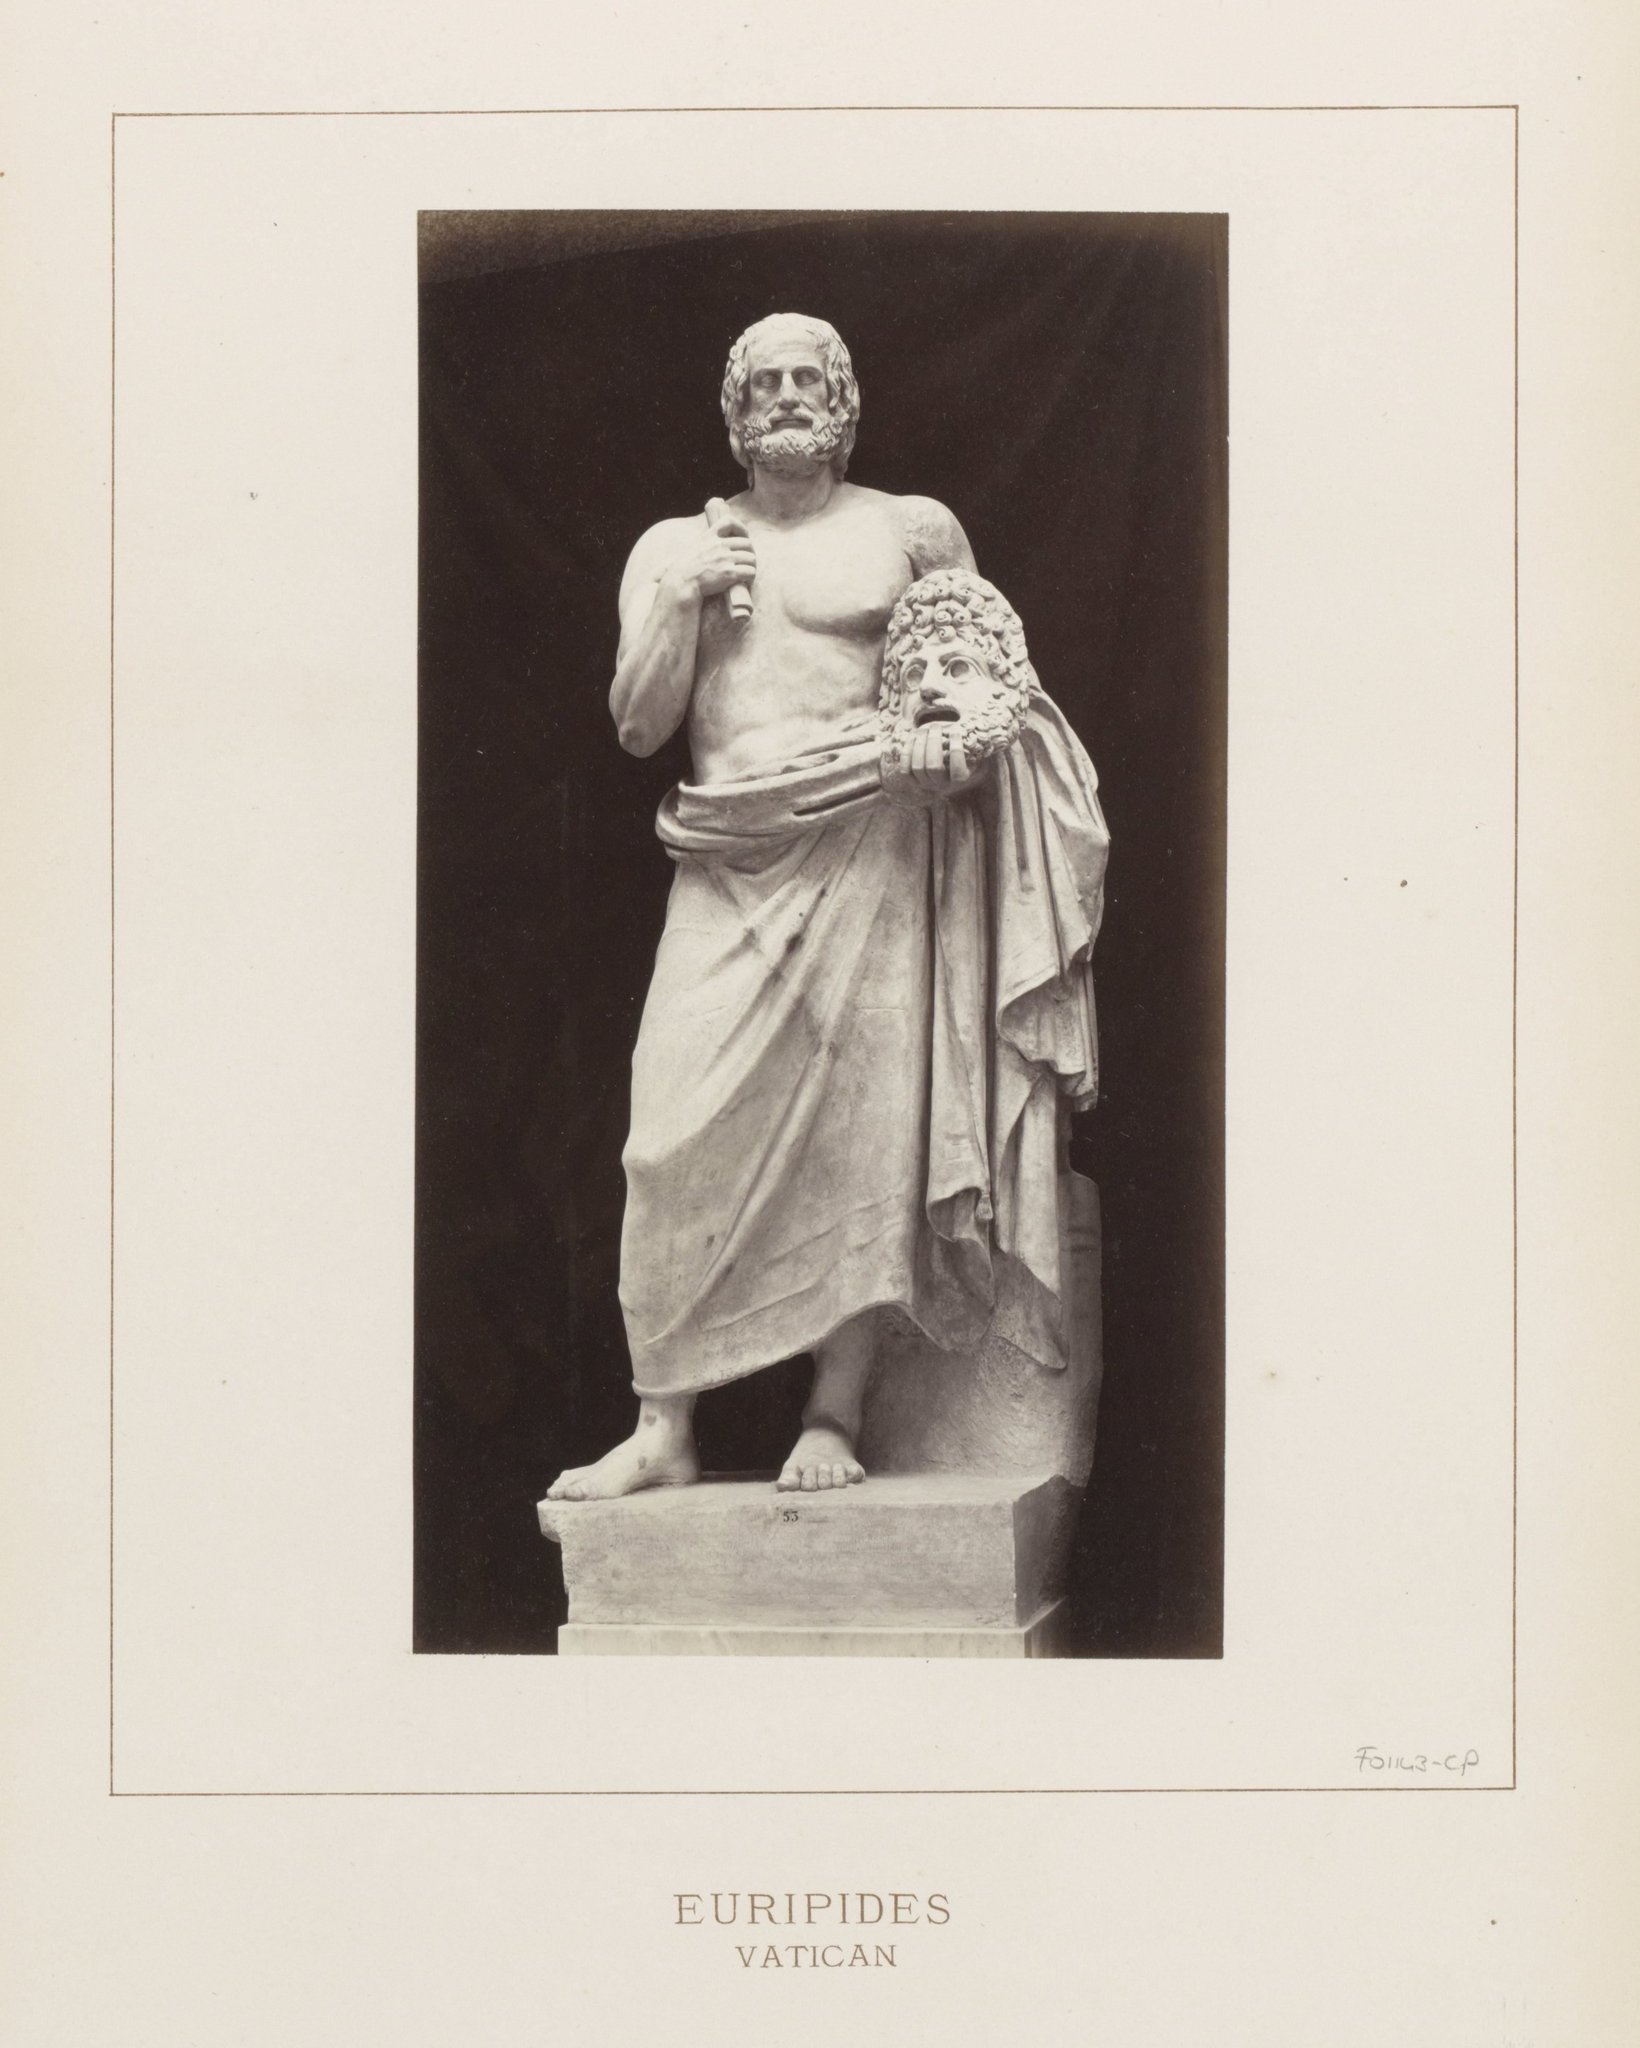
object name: photograph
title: Euripides, Vatican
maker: Anonymous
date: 1860-1900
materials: photographic support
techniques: albumen print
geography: vatican city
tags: piece of sculpture, reproduction of a piece of sculpture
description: Onderdeel van Fotoalbum met opnames van bezienswaardigheden en kunstwerken in Rome.